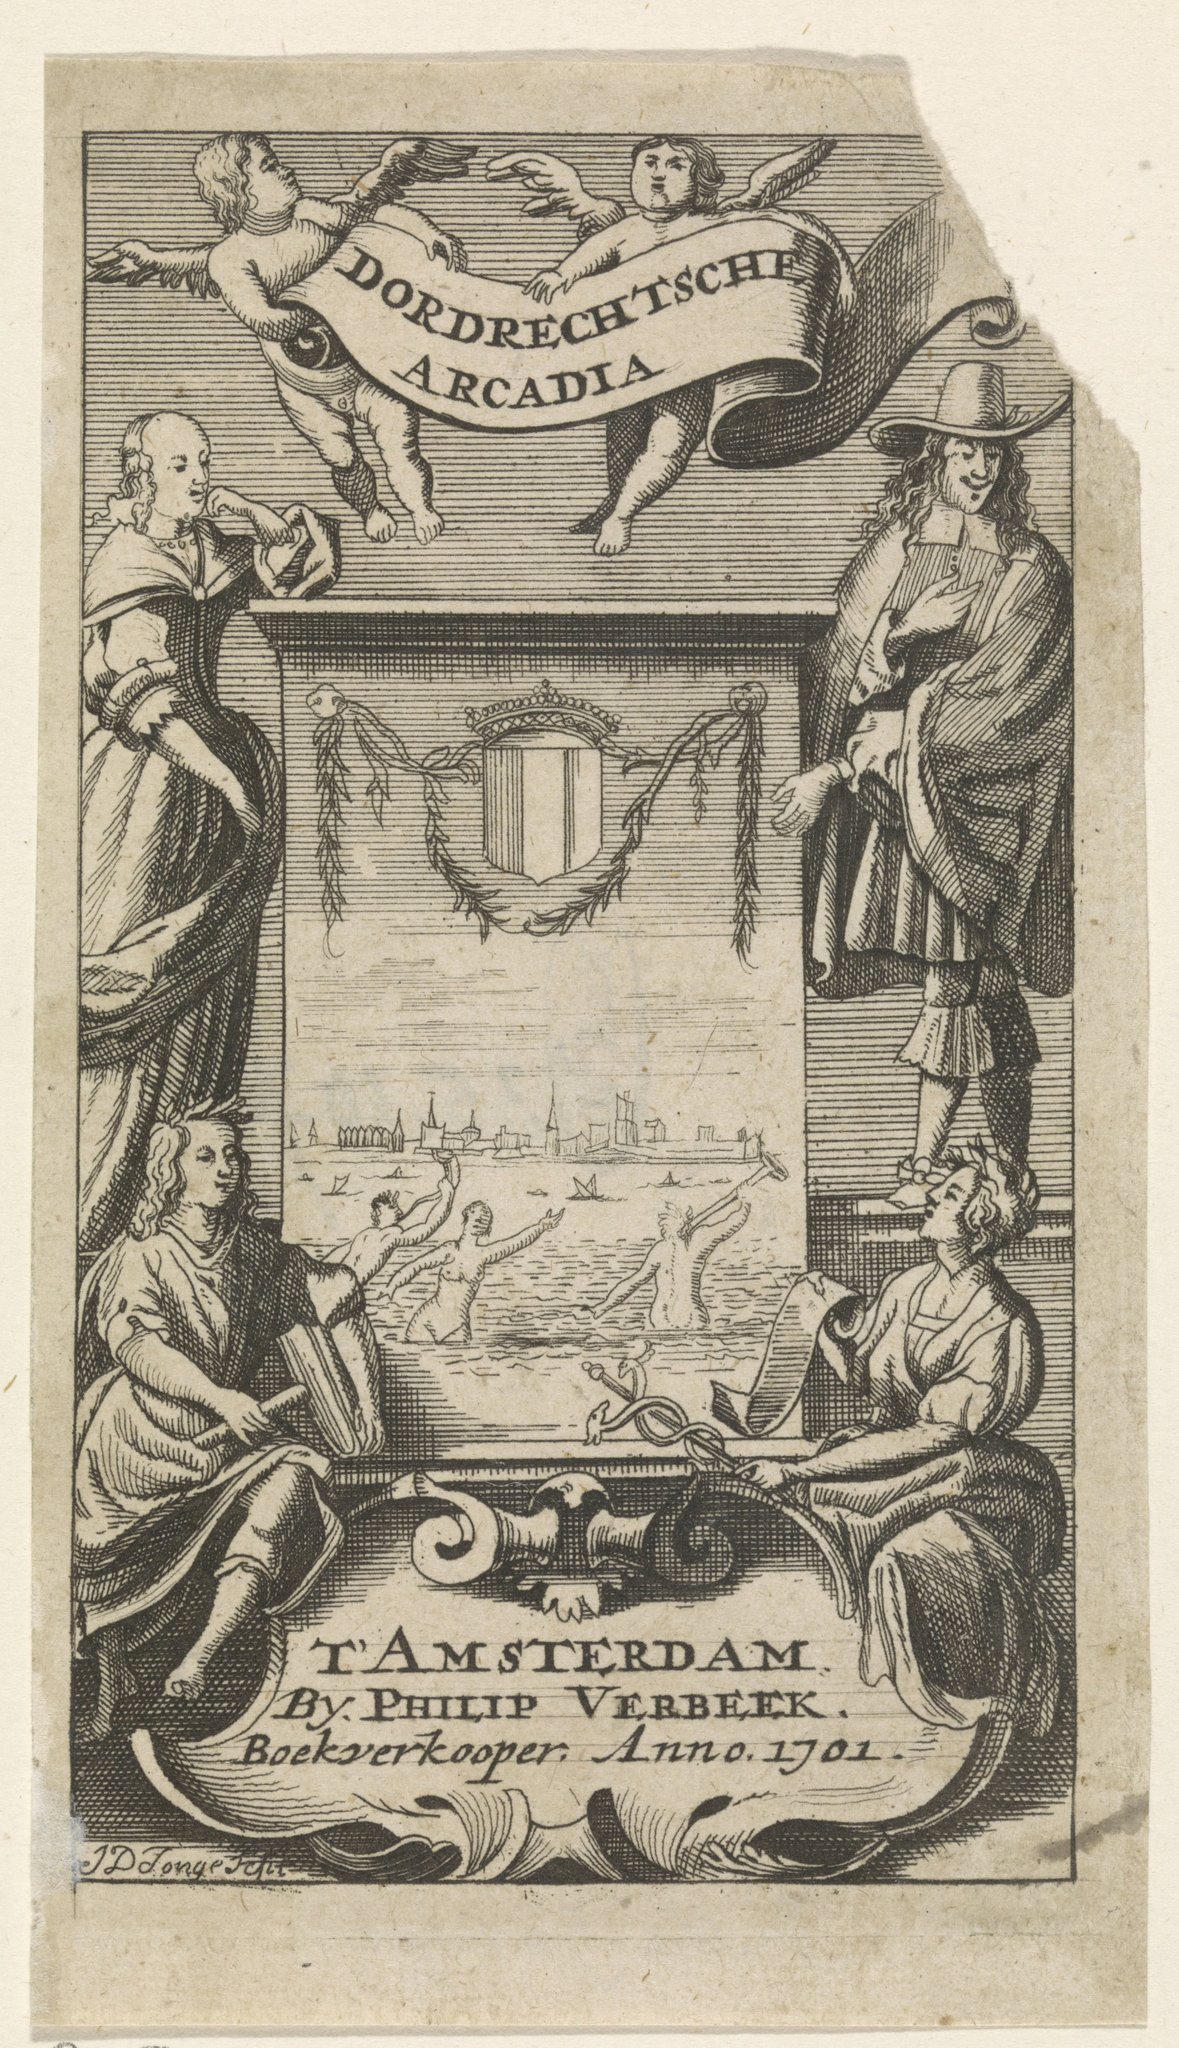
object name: print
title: Titelpagina voor: Dordrechtsche Arcadia, 1701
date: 1701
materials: paper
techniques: etching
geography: middelburg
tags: dordrecht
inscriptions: collector's mark: Lugt 2760, collector's mark: Lugt 2228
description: Vier figuren rondom een kader waarop een wapenschild, een gezicht op de stad Dordrecht en figuren in het water. Daarboven twee engelen met banderol waarin de titel. In een cartouche de naam van de boekverkoper.